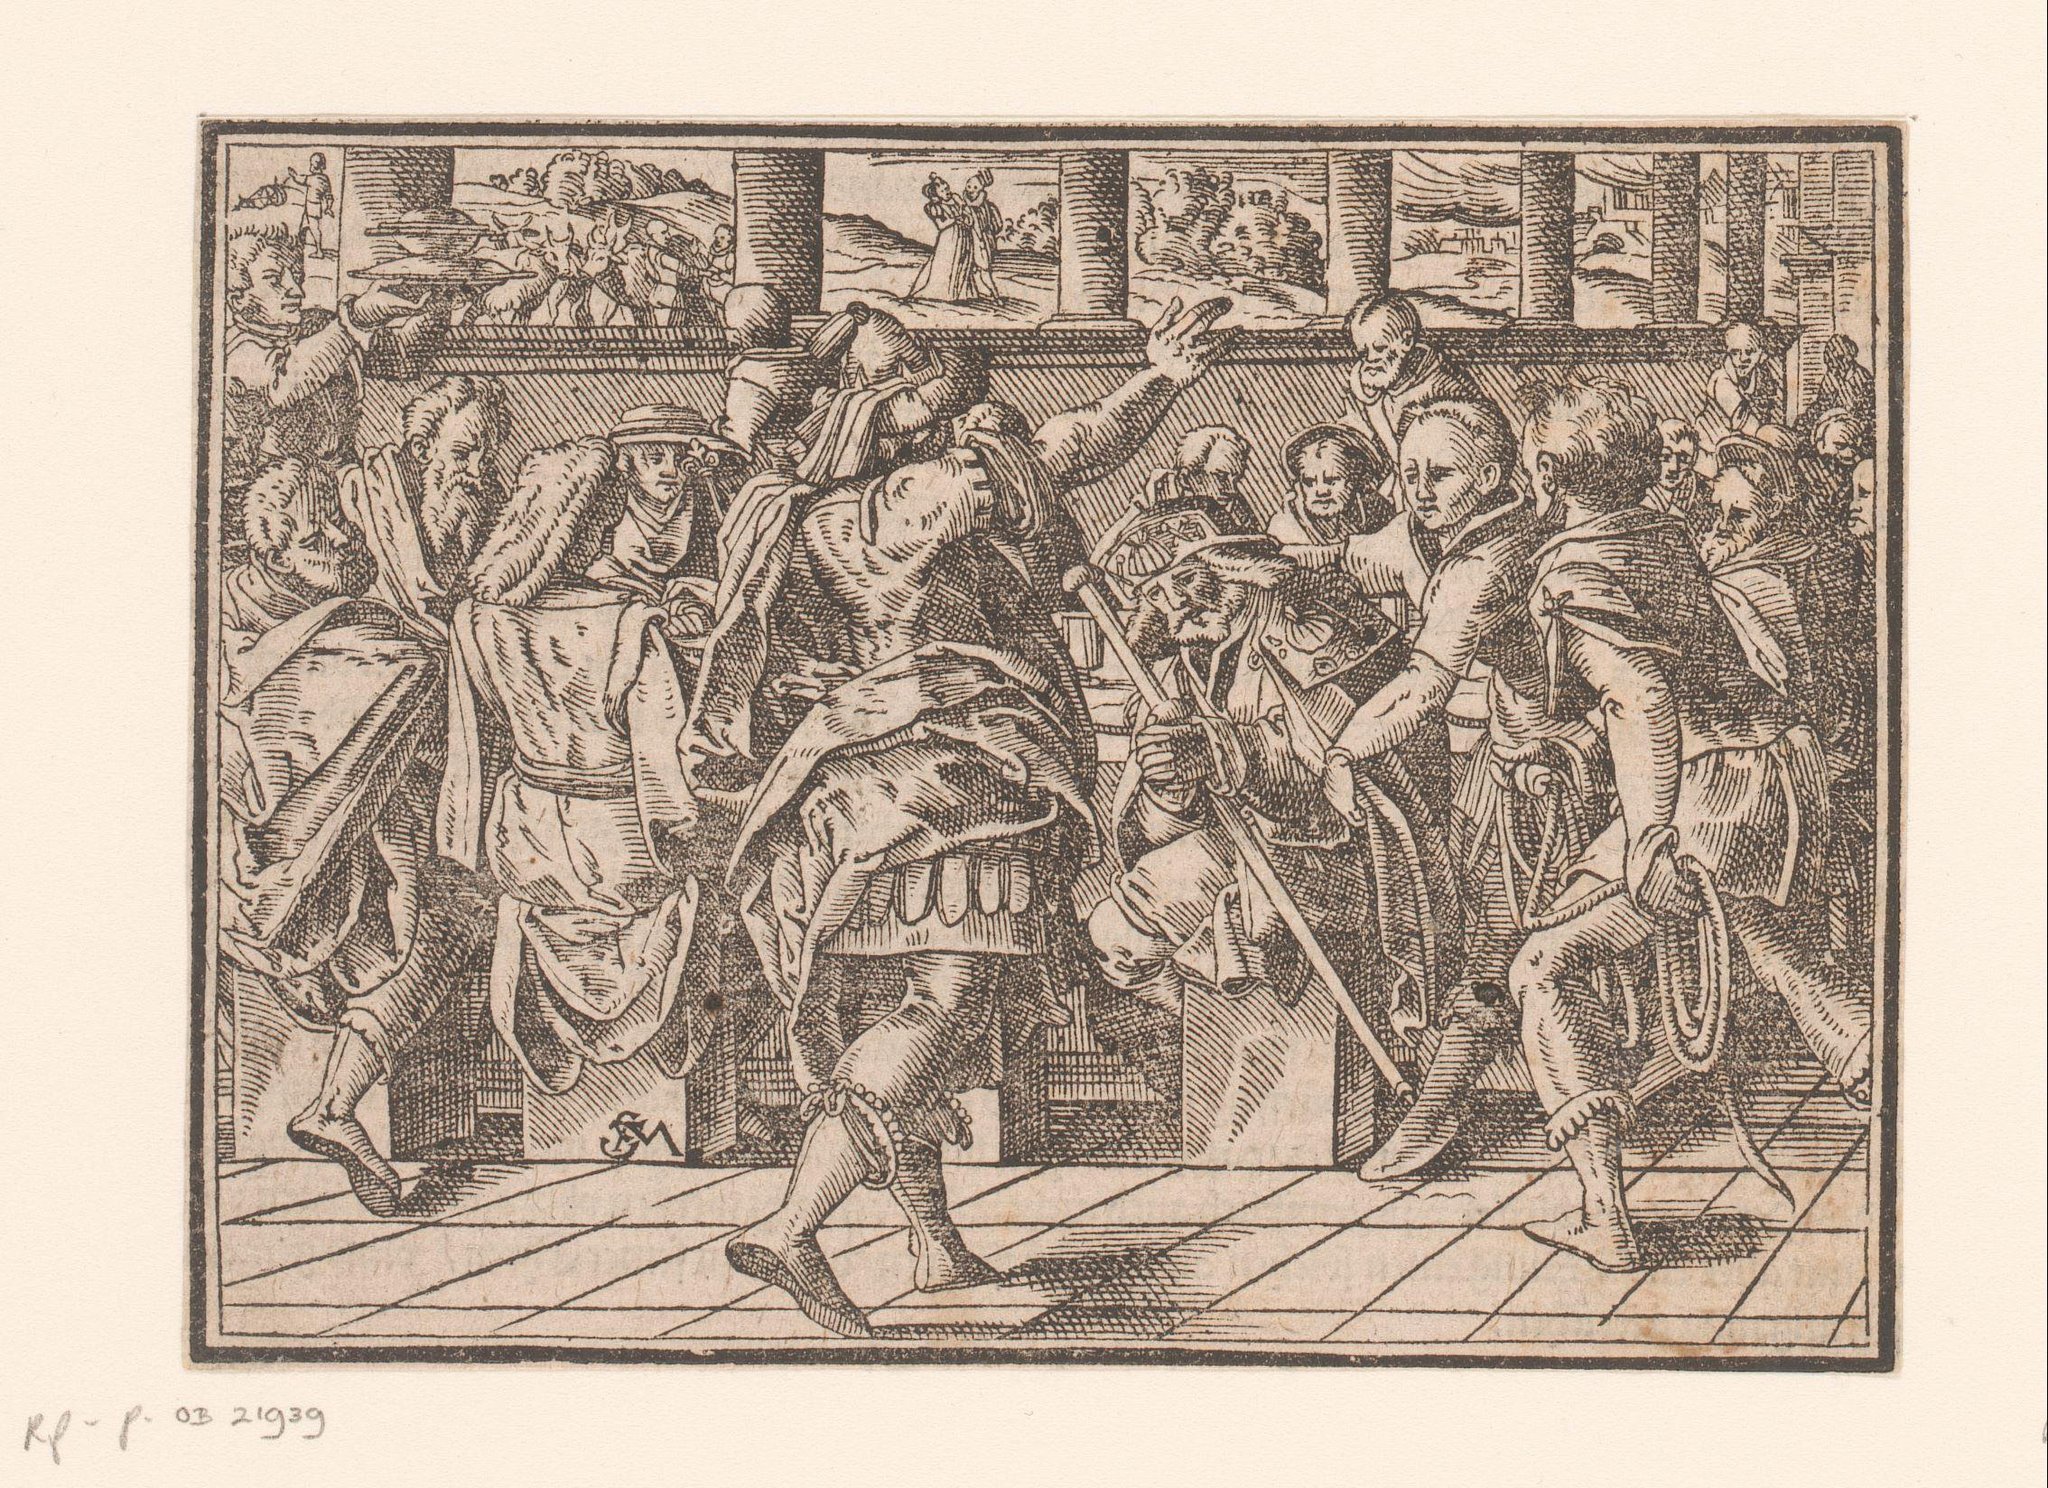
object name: print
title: Parabel van de onwaardige bruiloftsgast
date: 1625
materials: paper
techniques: woodcut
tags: the unworthy guest is dragged out ~ parable of the royal wedding-feast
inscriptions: collector's mark: Lugt 240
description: Prent mogelijk afkomstig uit: Novae Sacrorum Bibliorum Figurae (...). Straatsburg: Christoph von der Heyden, 1625.